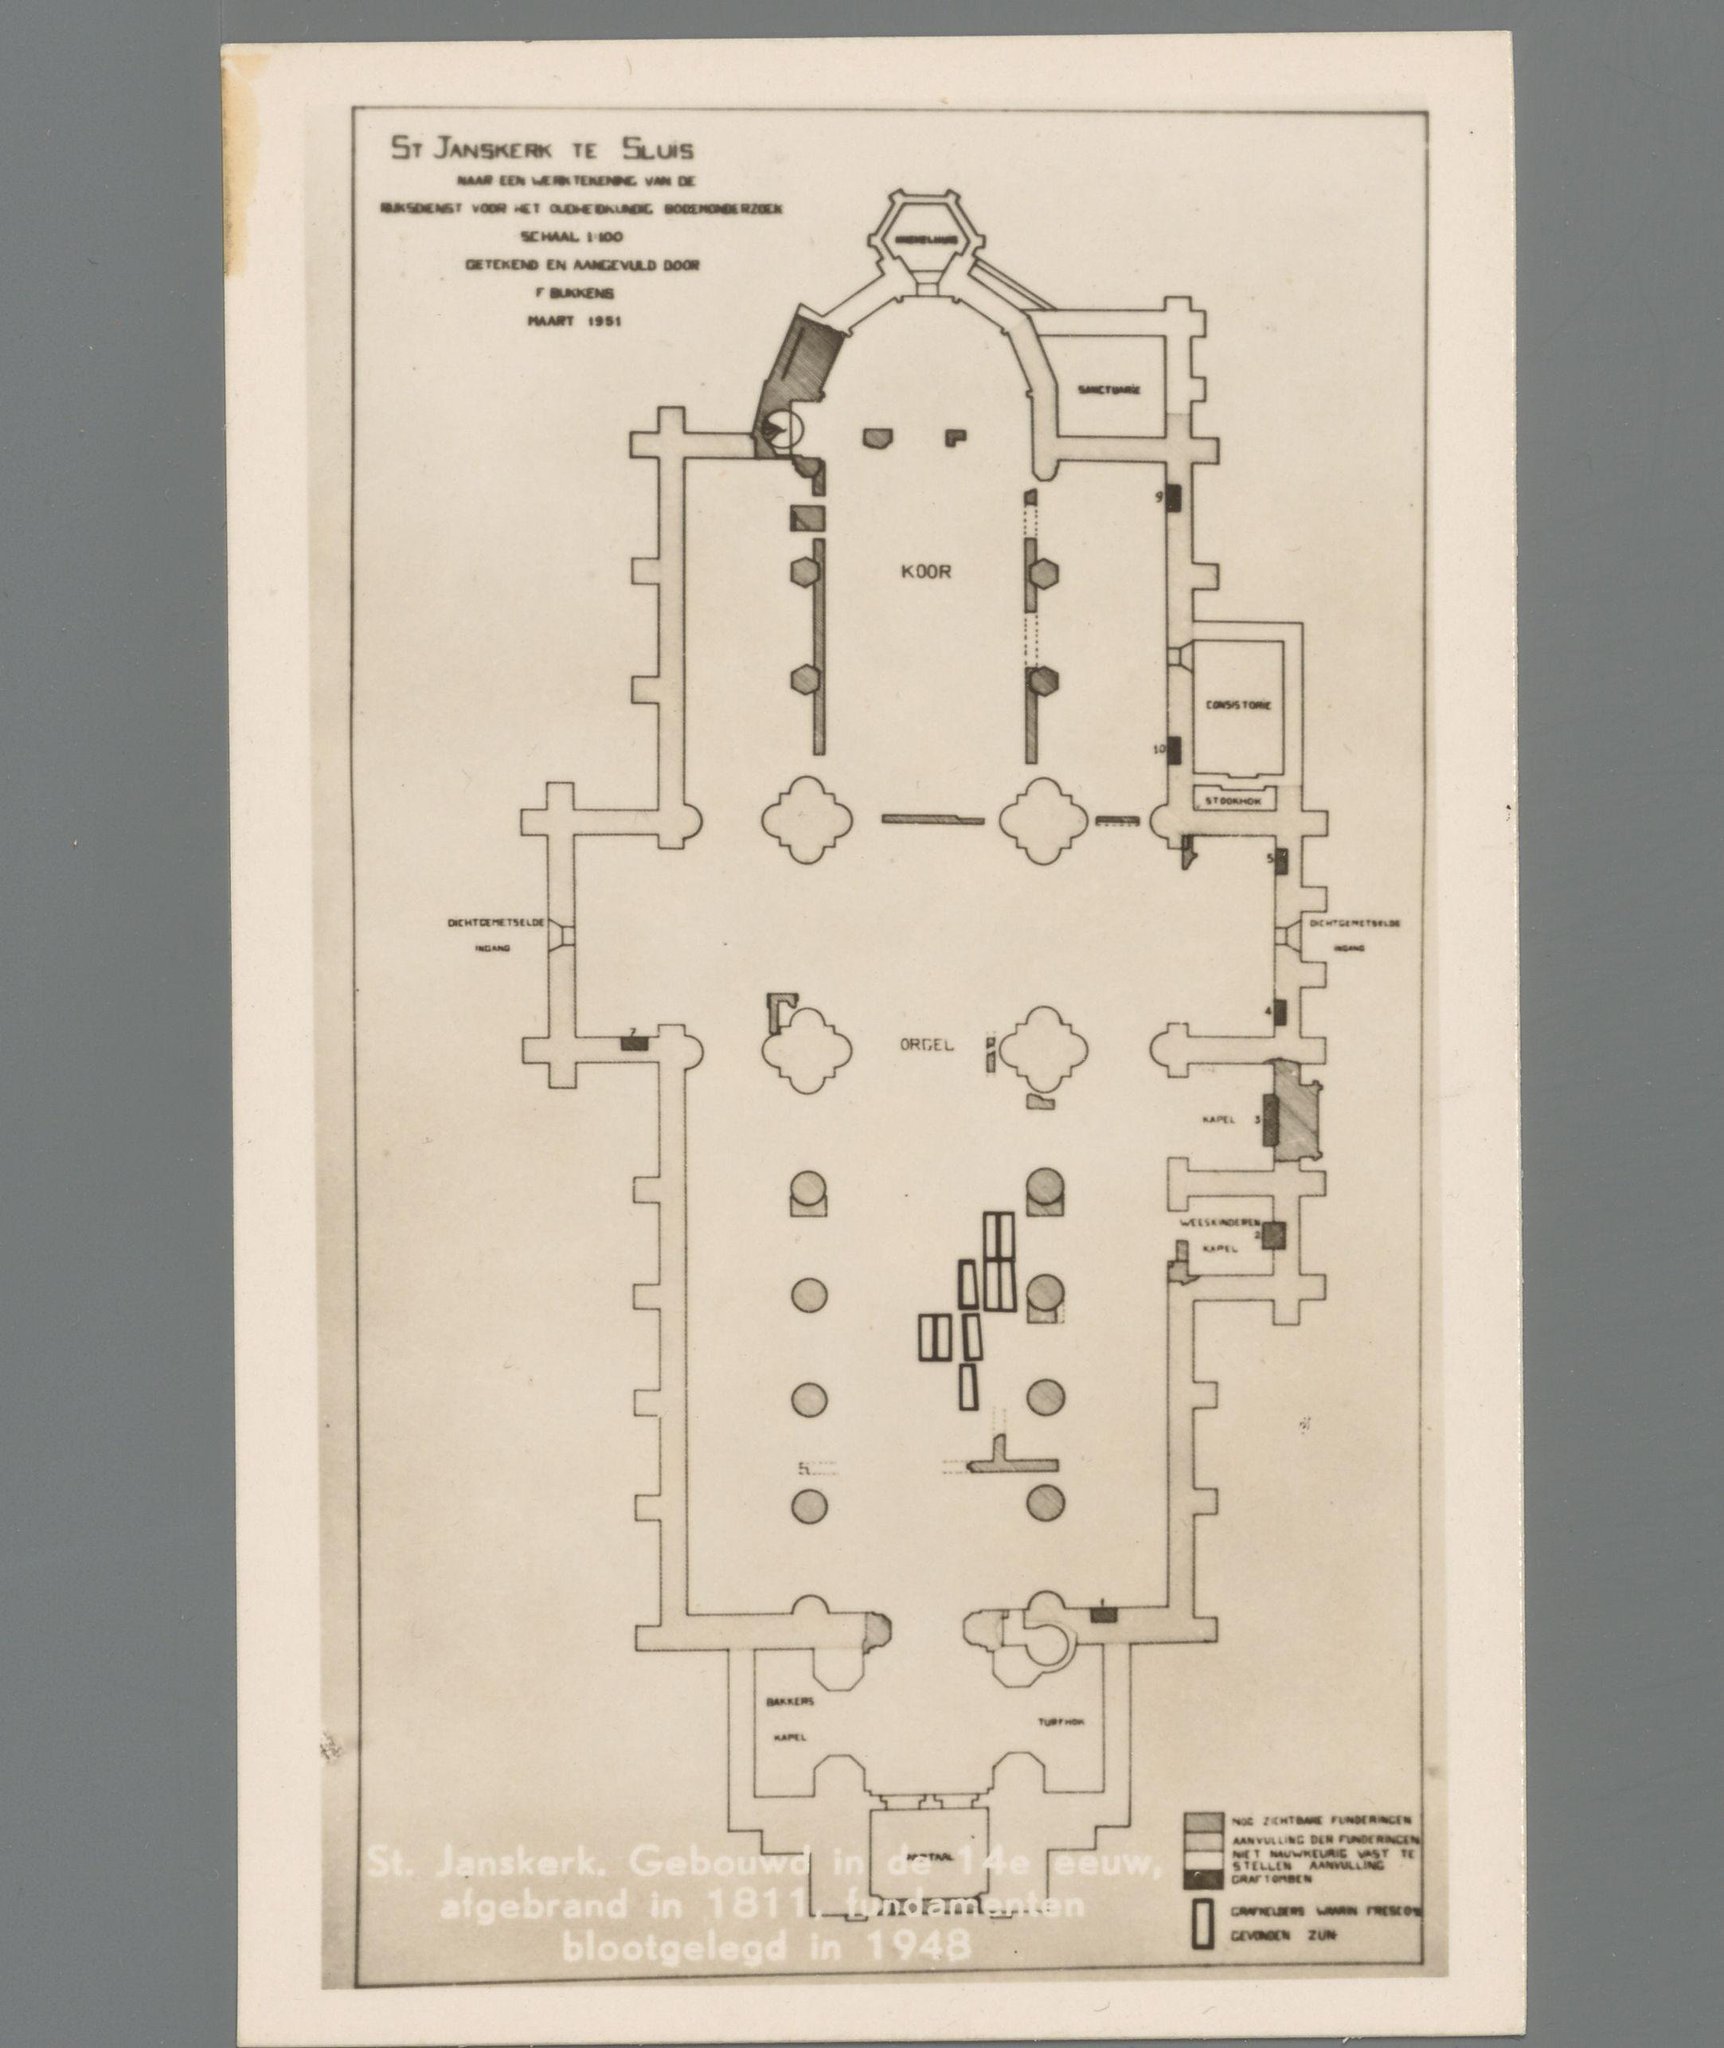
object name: ansichtkaart, prentbriefkaart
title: St. Janskerk. Gebouwd in de 14e eeuw, afgebrand in 1811, fundamenten blootgelegd in 1948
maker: Anonymous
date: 1905-1951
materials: paper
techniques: gelatin silver print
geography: sluis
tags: maps, atlases, interior of church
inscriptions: date